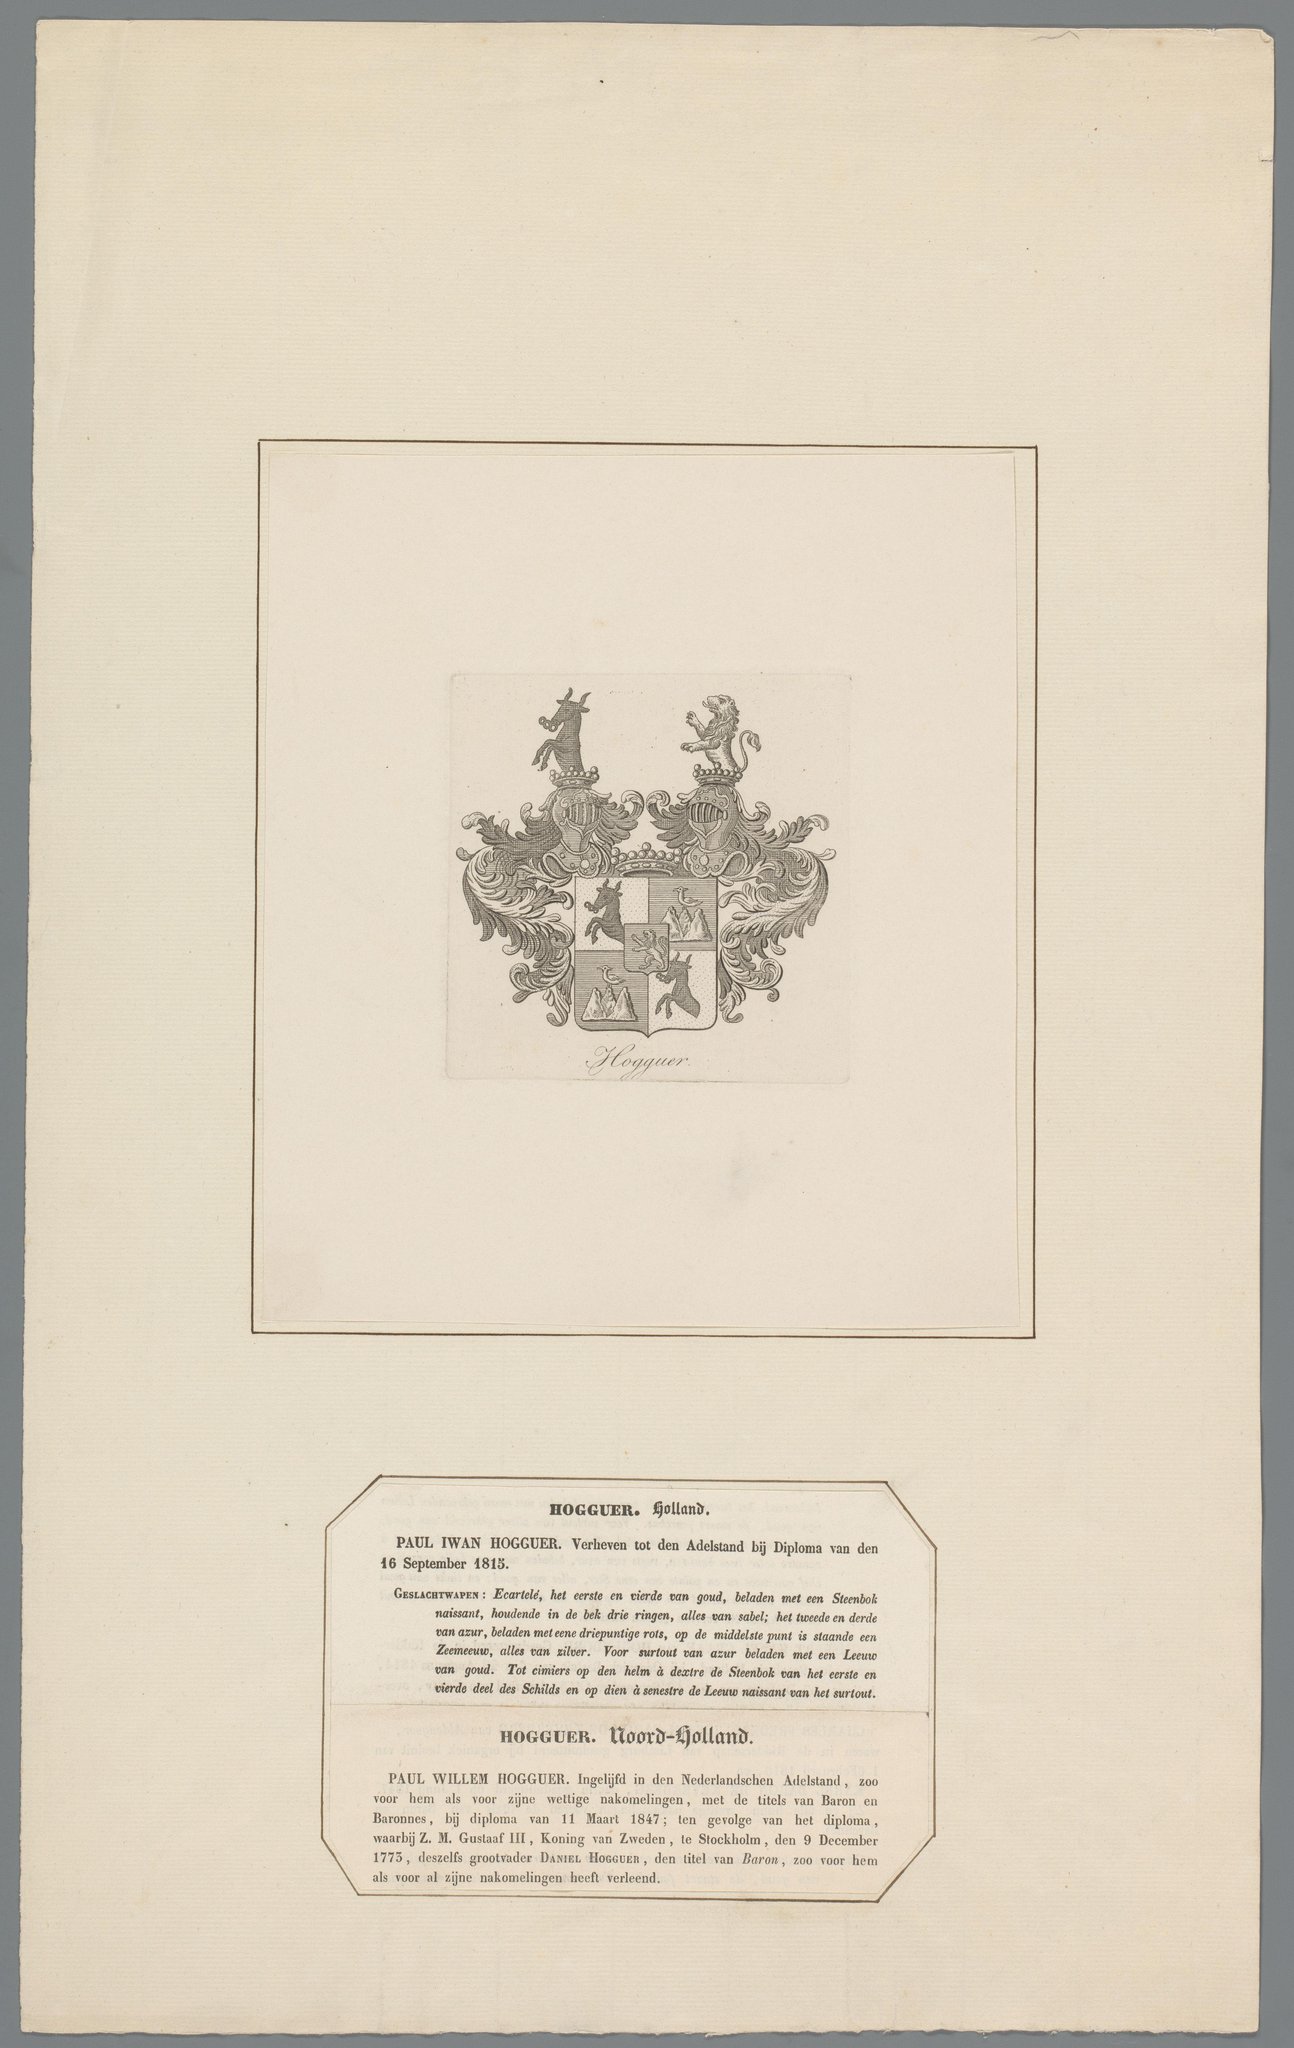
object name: print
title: Hogguer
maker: Anonymous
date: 1848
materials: paper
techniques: etching, letterpress printing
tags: armorial bearing, heraldry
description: Prent en tekst uit: Weleveld, L.A. van. Handboek van den Nederlandschen adel. S.l.s.n., 1848.